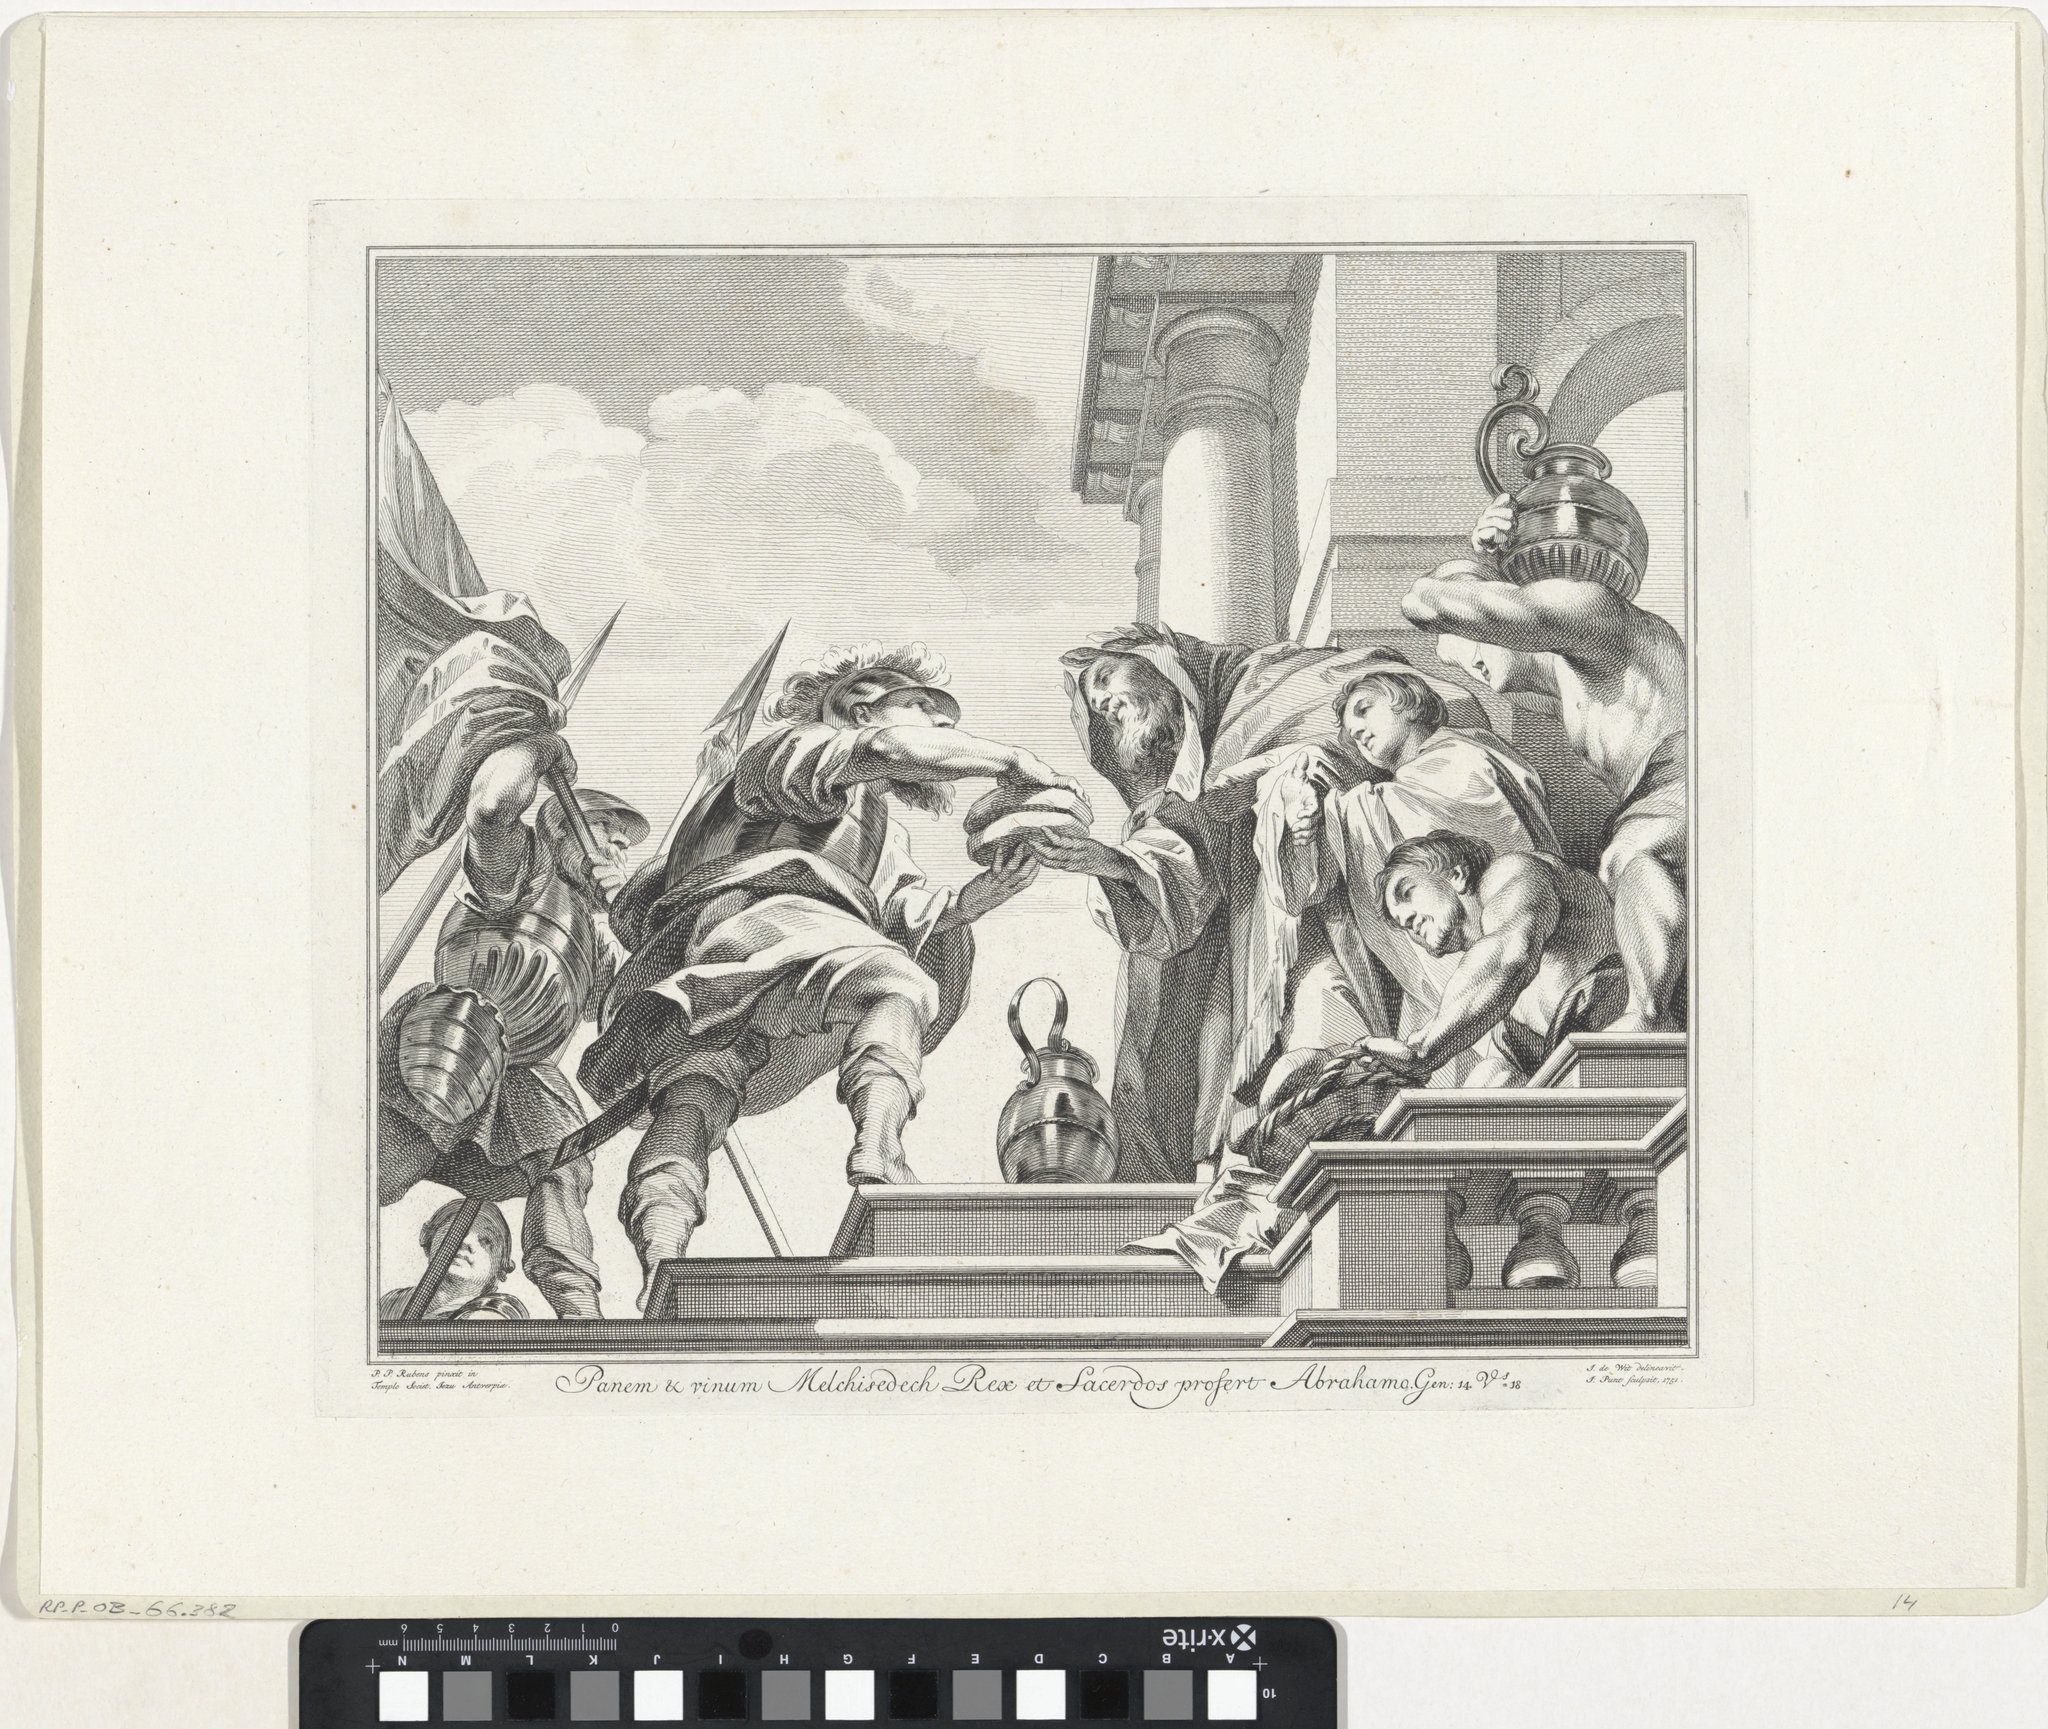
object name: print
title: Les plat-fonds ou les tableaux des galeries / De plafonds of gallerystukken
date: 1751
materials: paper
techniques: engraving, etching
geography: amsterdam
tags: the meeting of abraham and melchizedek, the high priest and king of salem, who brings bread and wine (genesis 14:18-20)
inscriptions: date: ‘1751’, collector's mark: Lugt 2228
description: Melchisedek staat op een trap en overhandigt twee broden aan Abraham. Onder de rechthoekige voorstelling een vers in het Latijn uit Gen. 14:18.